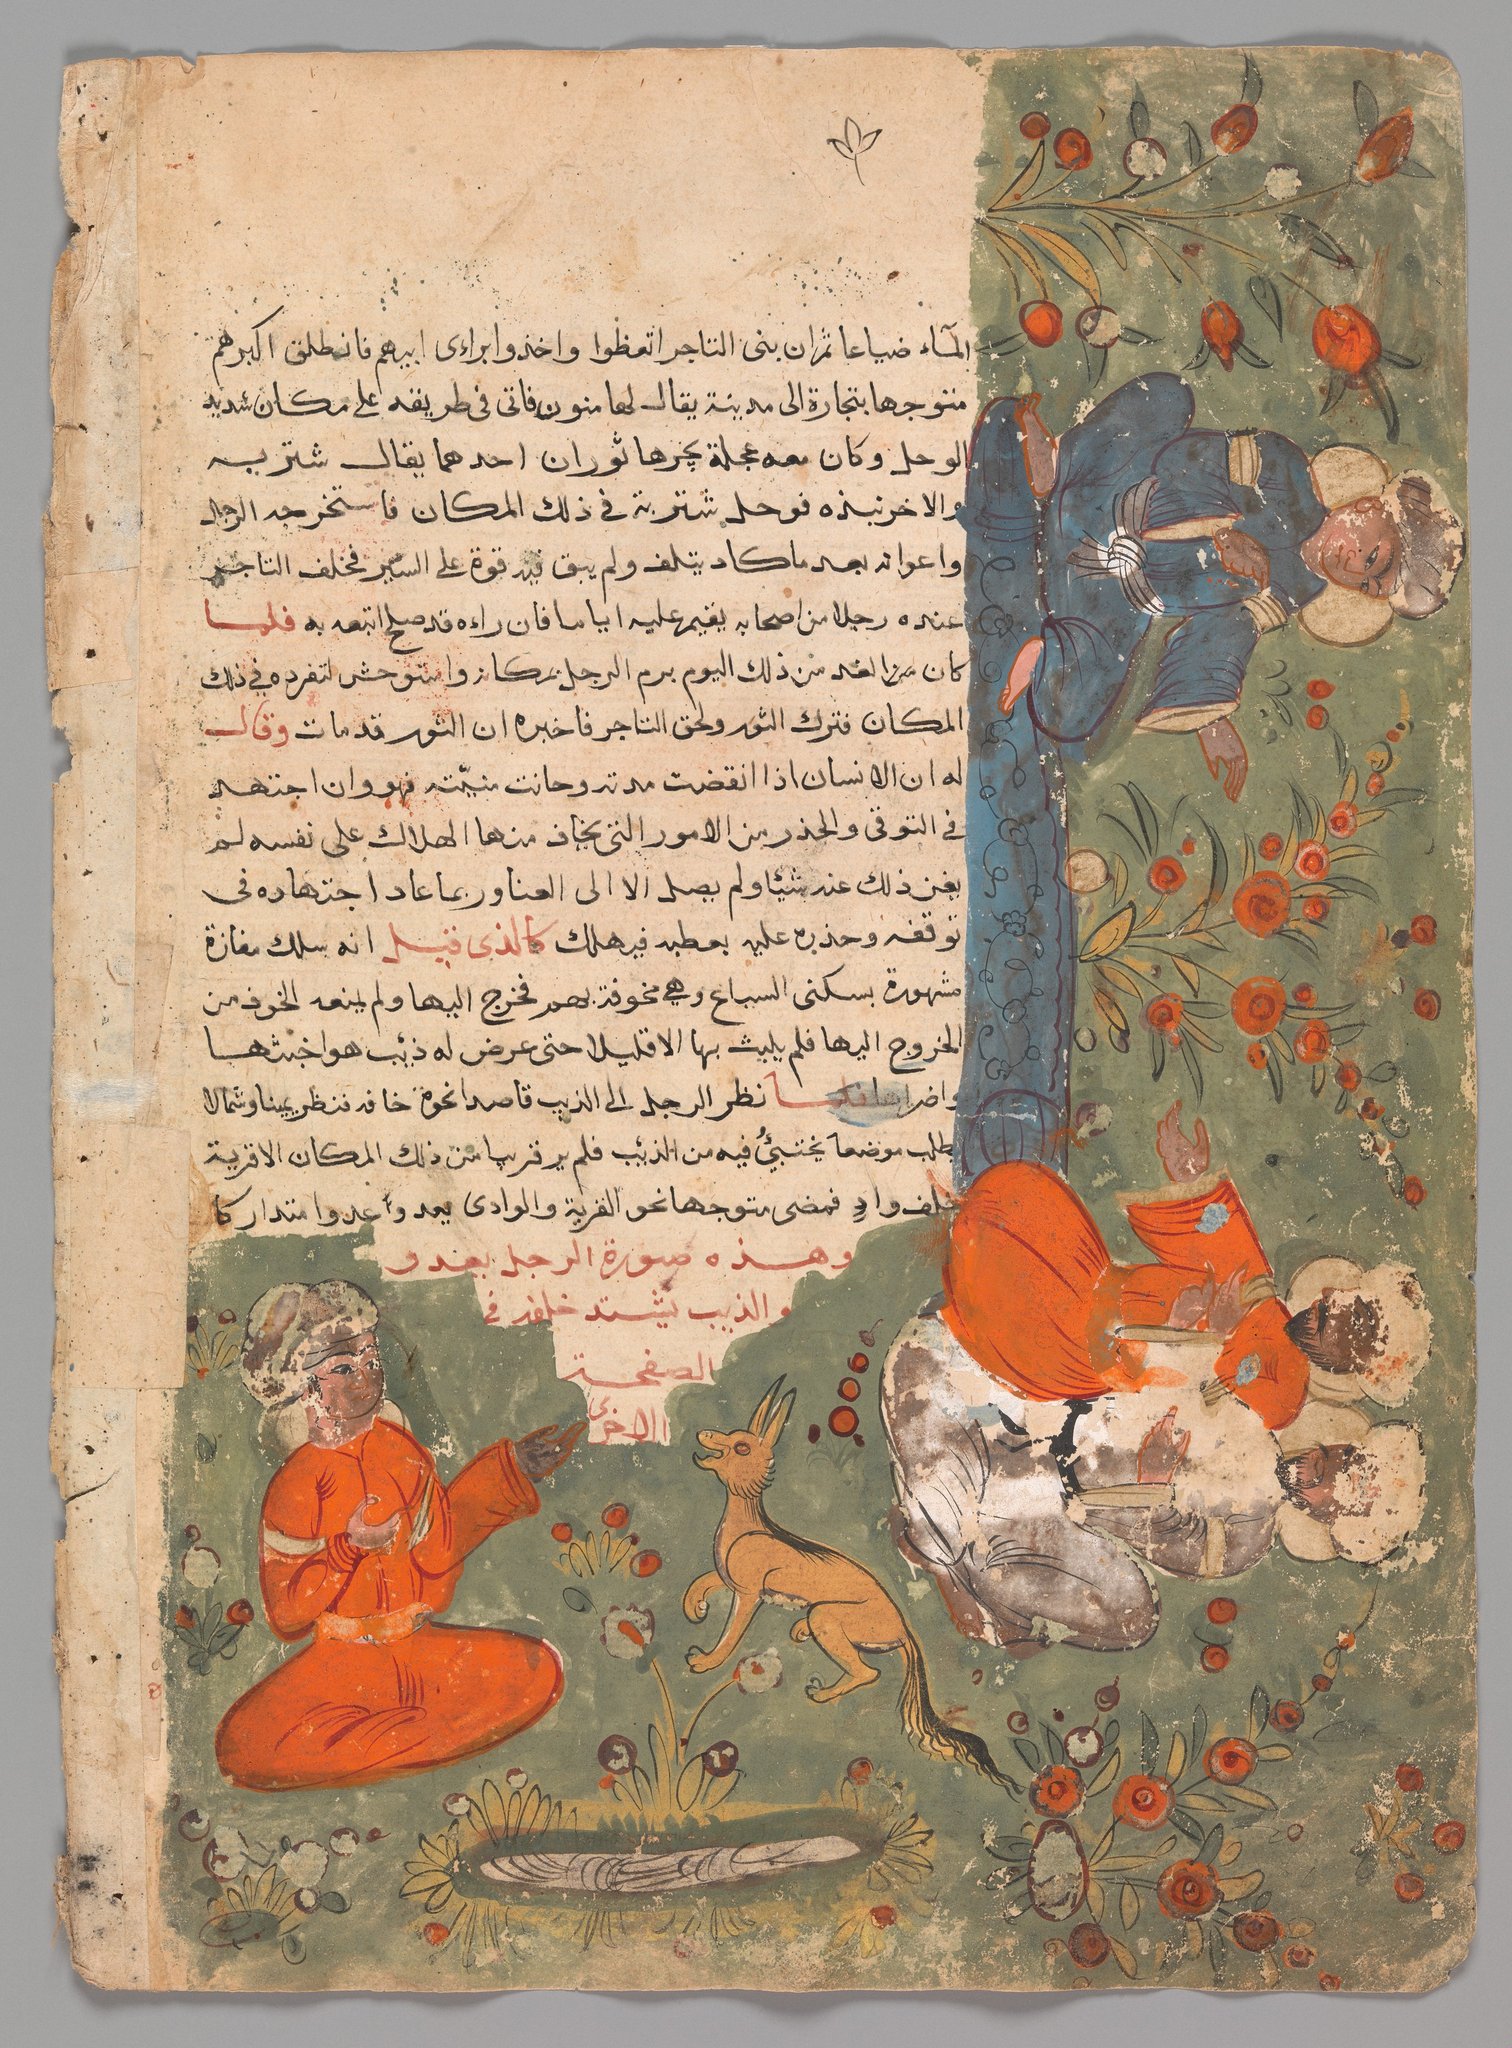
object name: folio from an illustrated manuscript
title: Folio from a Kalila wa Dimna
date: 1526-1550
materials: ink, paper, watercolor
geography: india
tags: animals,men,arabic,flowers,calligraphy